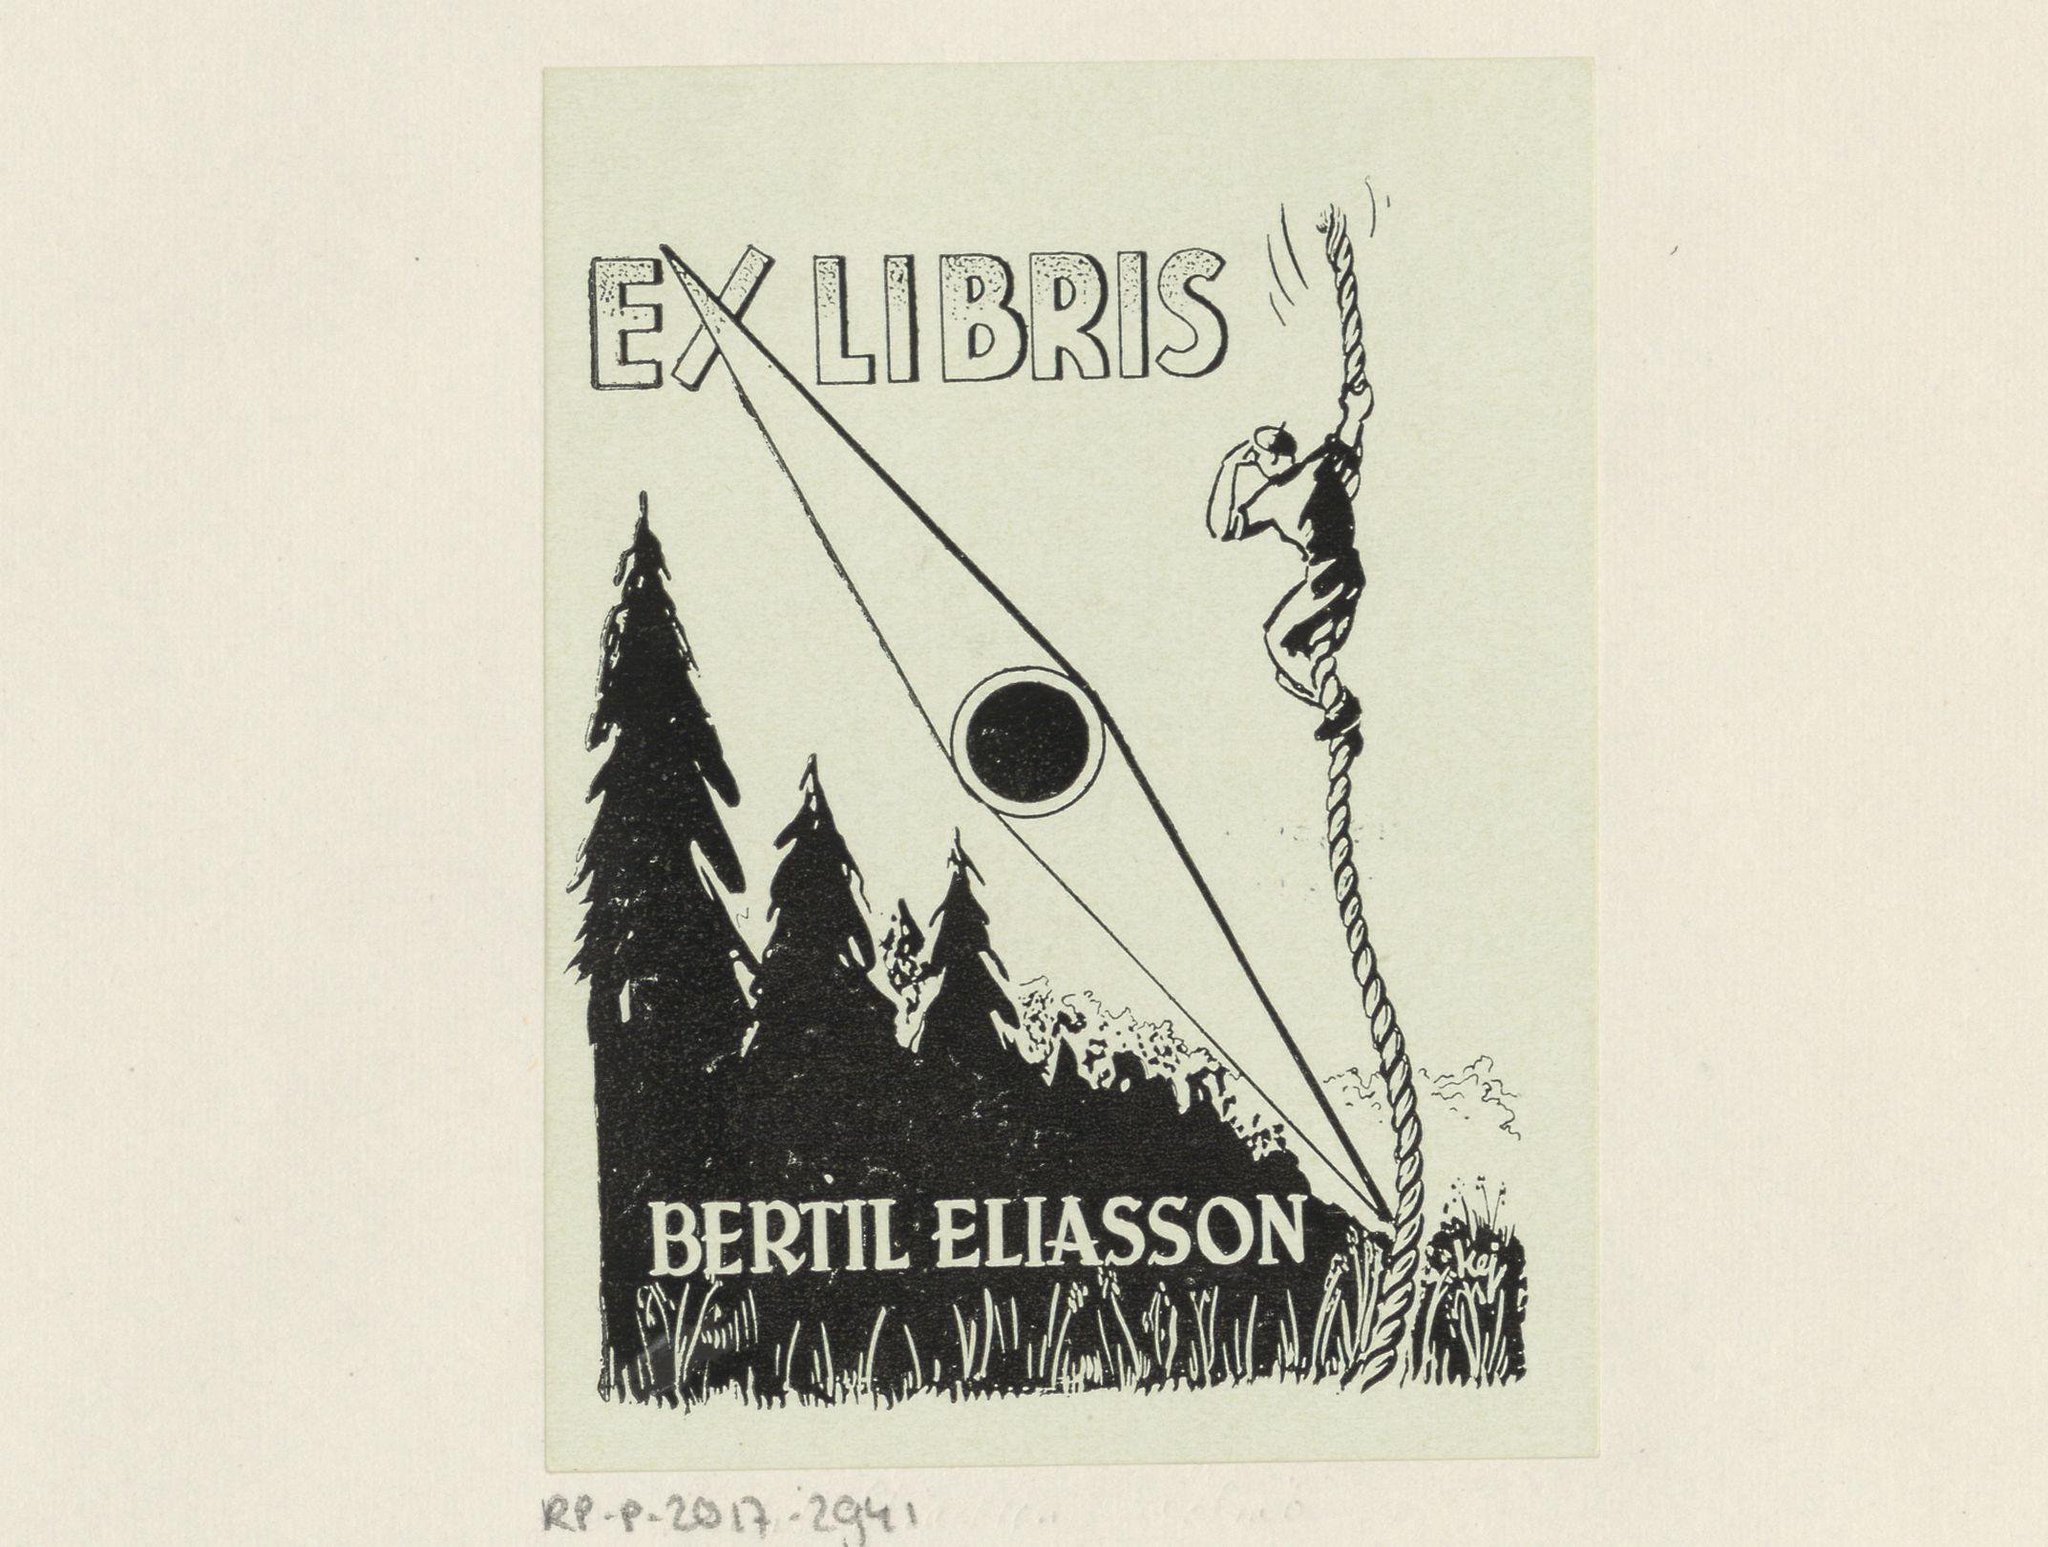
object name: bookplate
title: Ex libris van Bertil Eliasson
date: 1948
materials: paper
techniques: printing block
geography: sweden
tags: forest of coniferous trees, standing on one leg, the other leg forward, tools, aids, implements ~ crafts and industries: rope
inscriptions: collector's mark: ‘Bertil Eliasson / Sturegatan 9a / Malmö / Sweden’